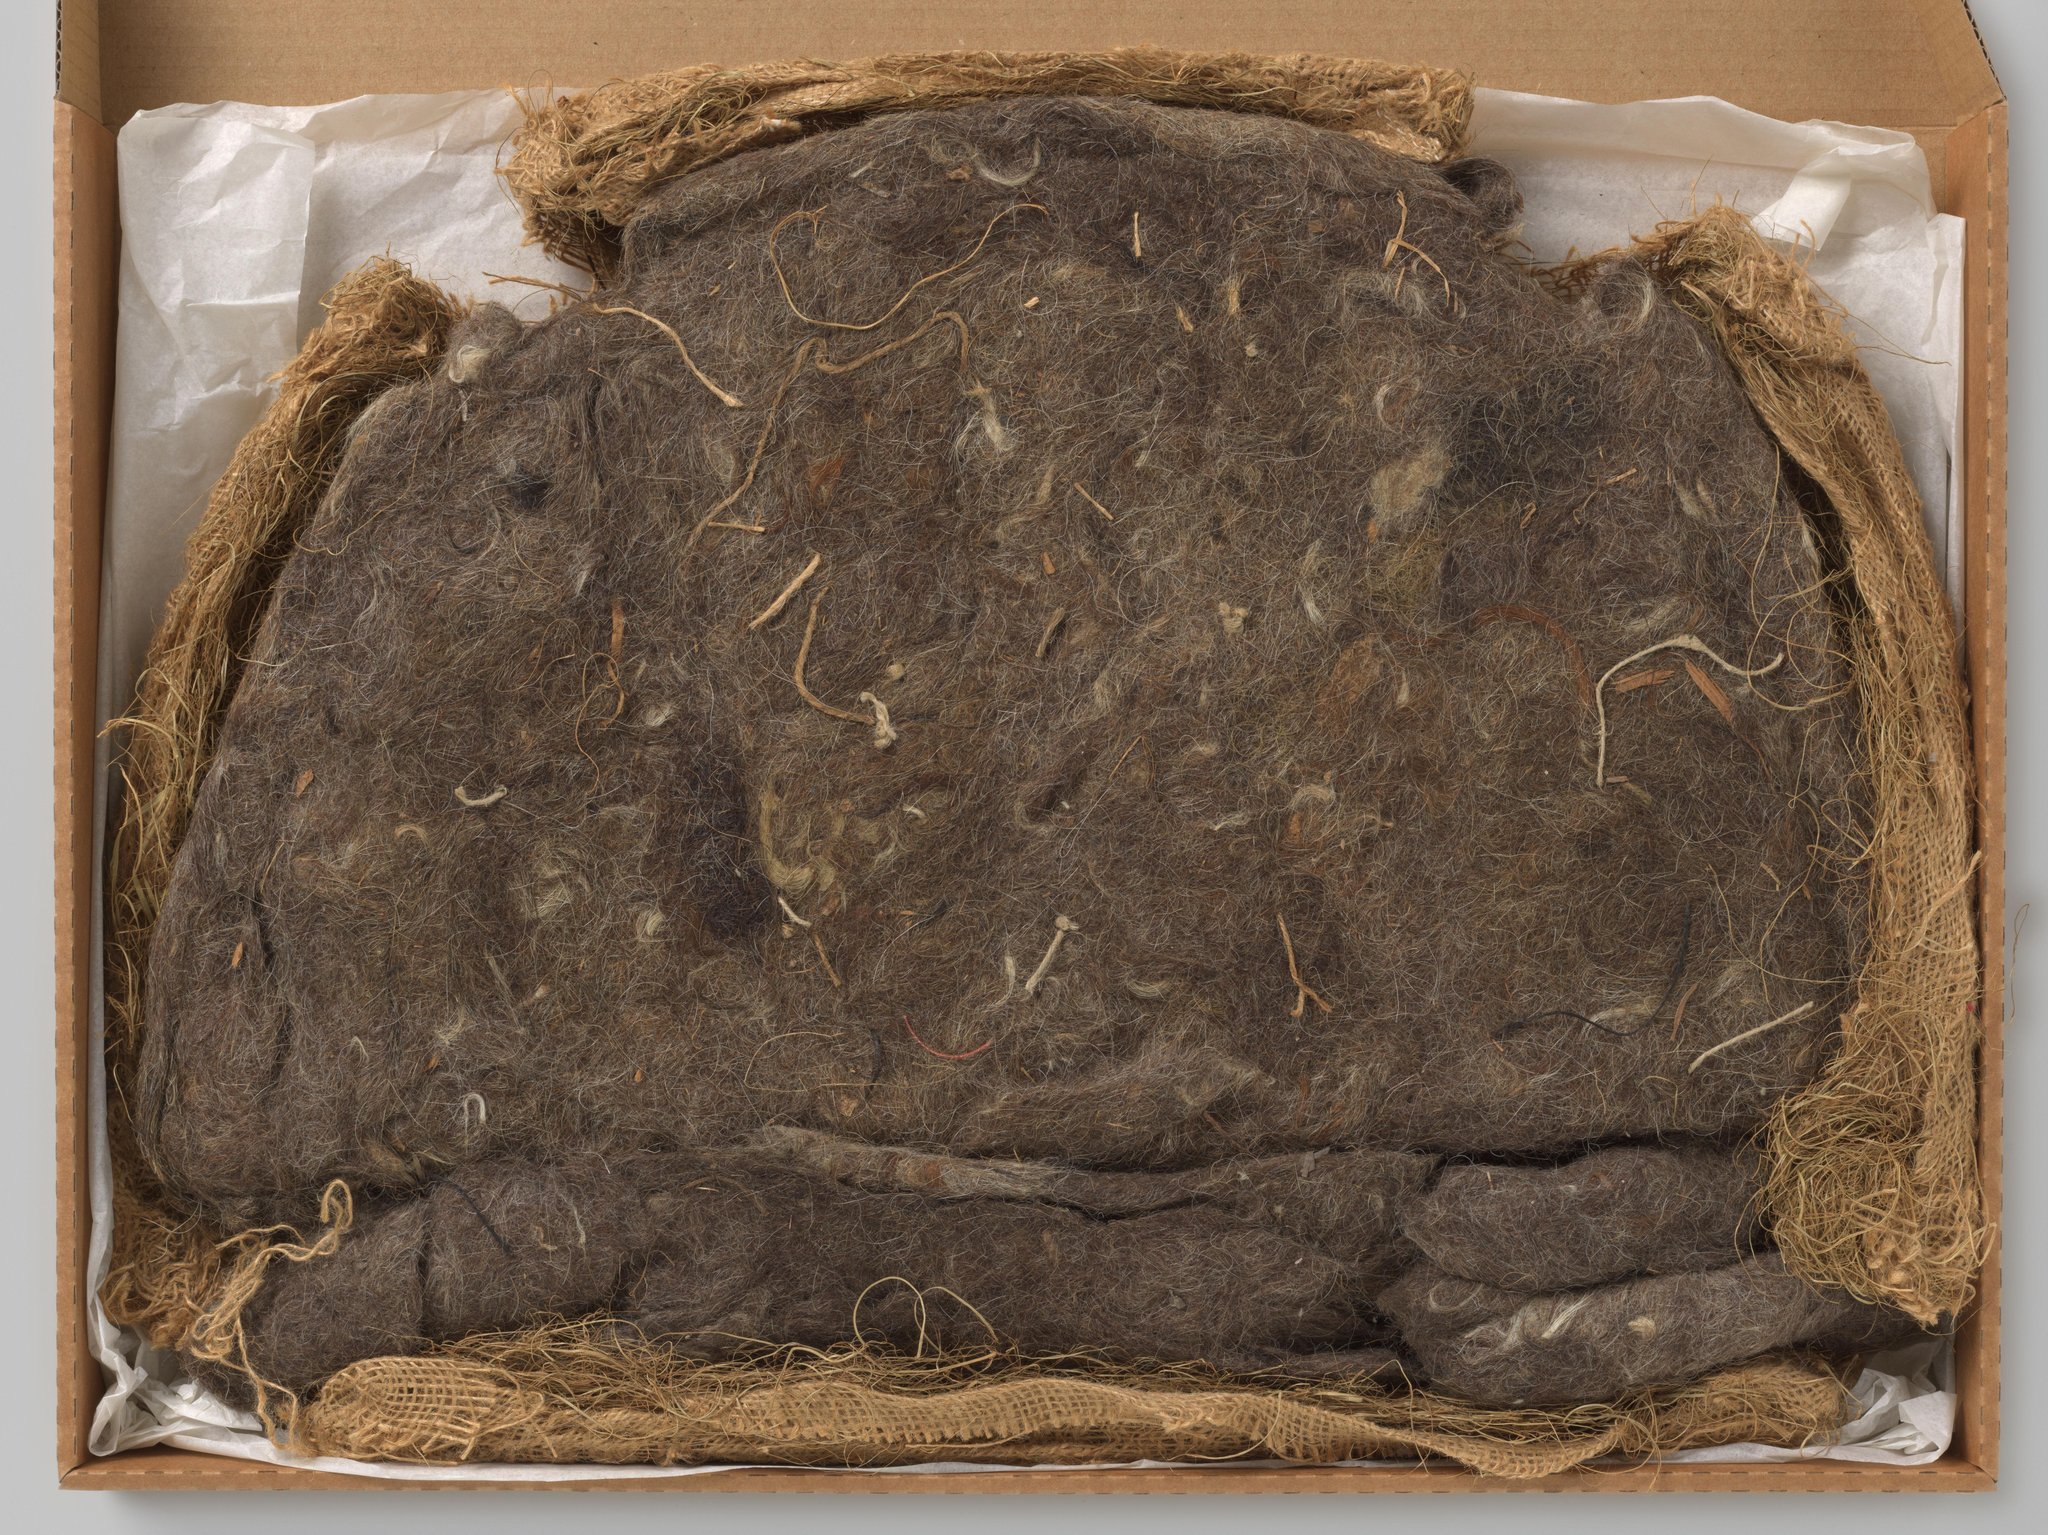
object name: suite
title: Vulling van een armstoelbekleding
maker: Anonymous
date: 1785-1800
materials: hair, jute, wool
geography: northern netherlands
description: Vulling van een armstoelbekleding. De vulling heeft een afgeronde kant en bestaat uit wol en paardenhaar, bedekt met jute. Behorende bij een armstoel van iepenhout met een beklede zitting en rustend op conische, gecanneleerde voorpoten en flauw wijkende achterpoten (BK-1959-117-A).